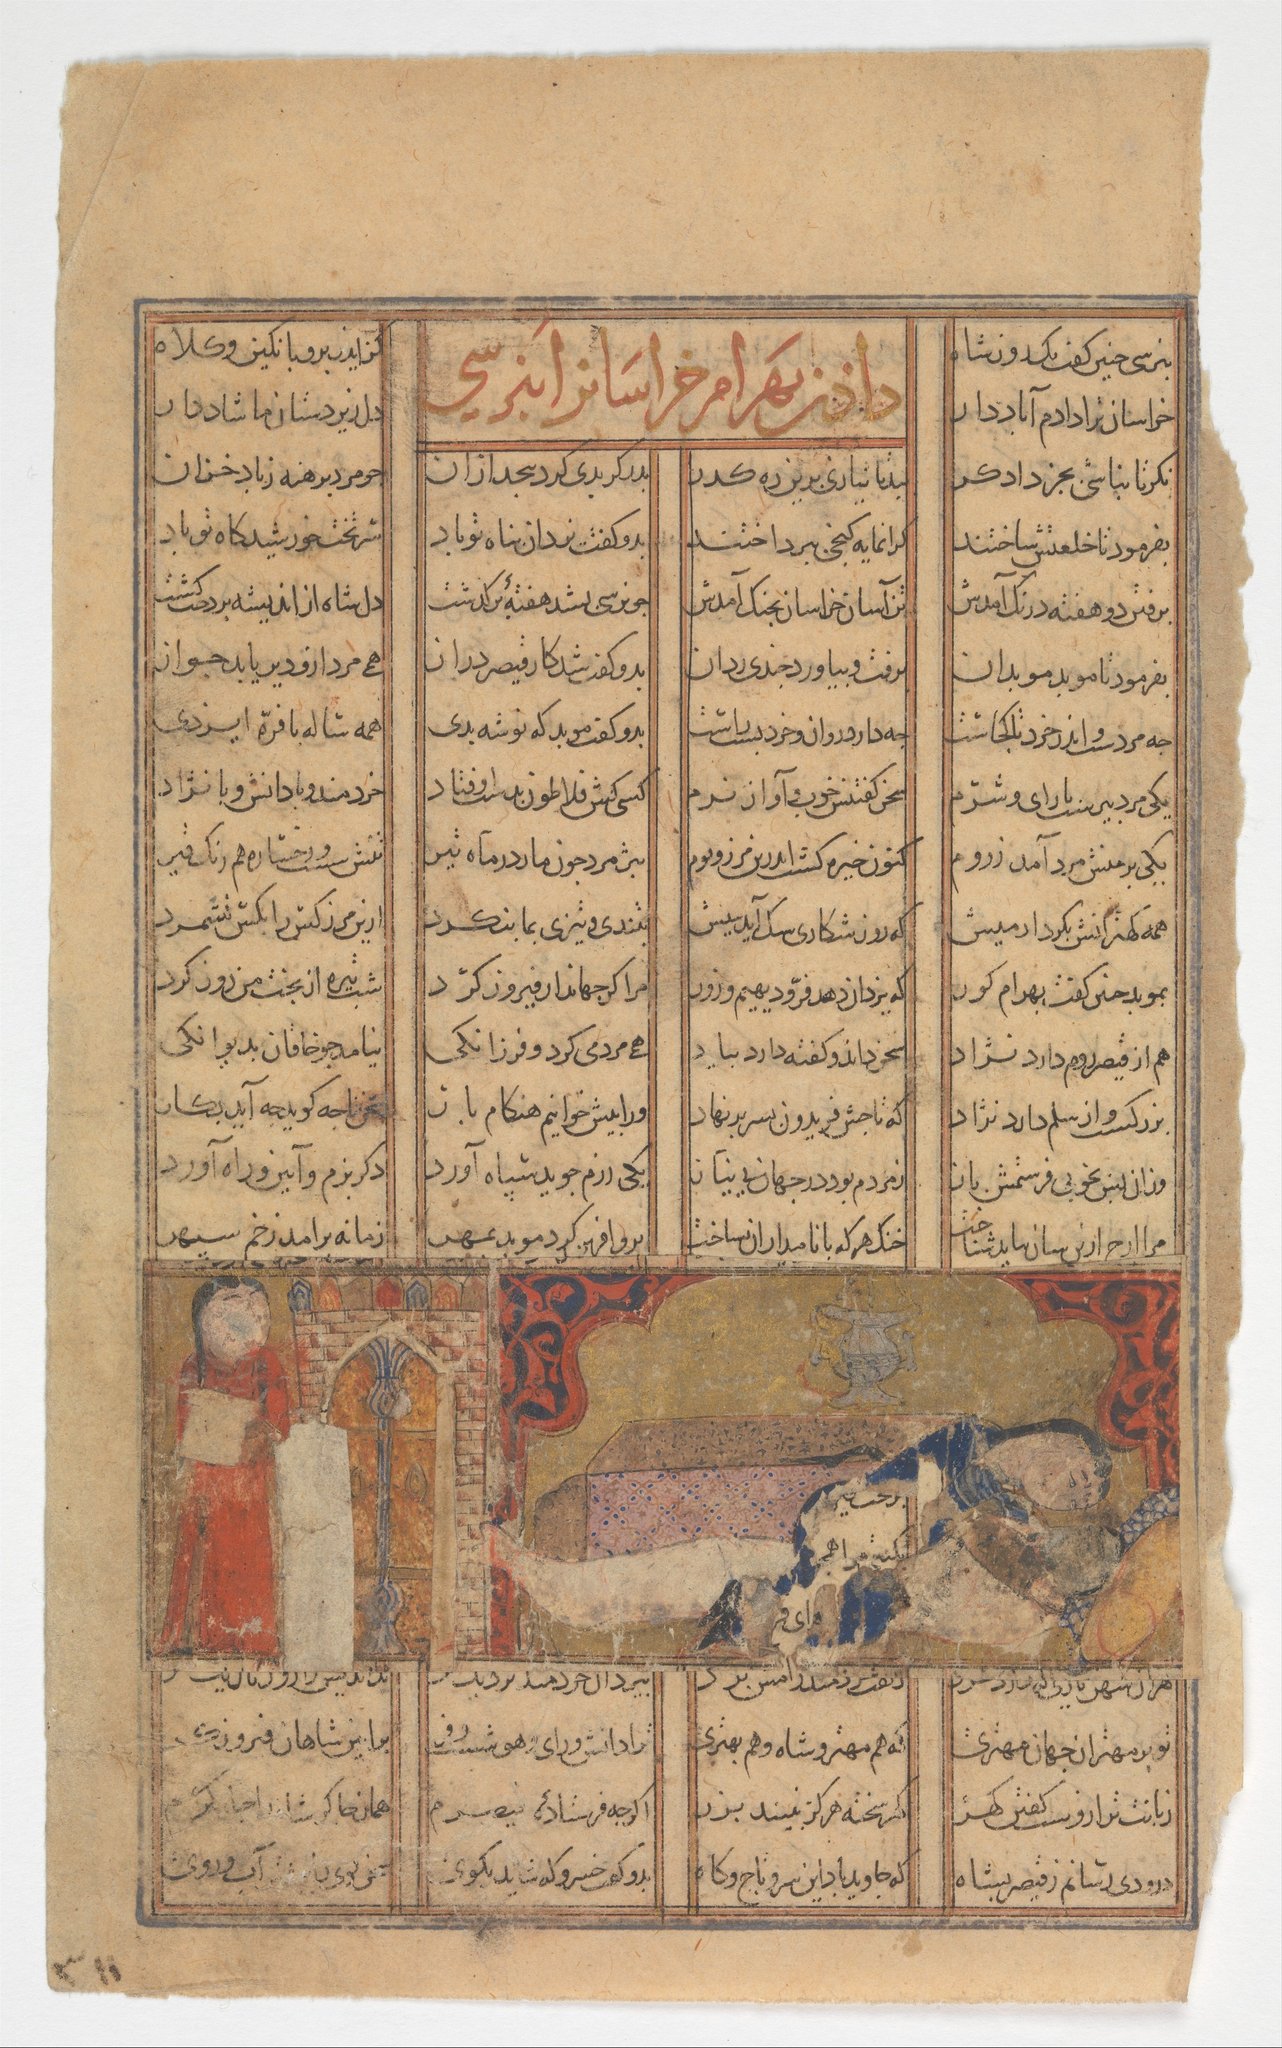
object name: folio from an illustrated manuscript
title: "Death of Bahram Chubina?", Folio from a Shahnama (Book of Kings)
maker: abu'l qasim firdausi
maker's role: author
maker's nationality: iranian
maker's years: 935-1020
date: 1330-1340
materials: gold, ink, paper, watercolor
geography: iran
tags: men,women,death